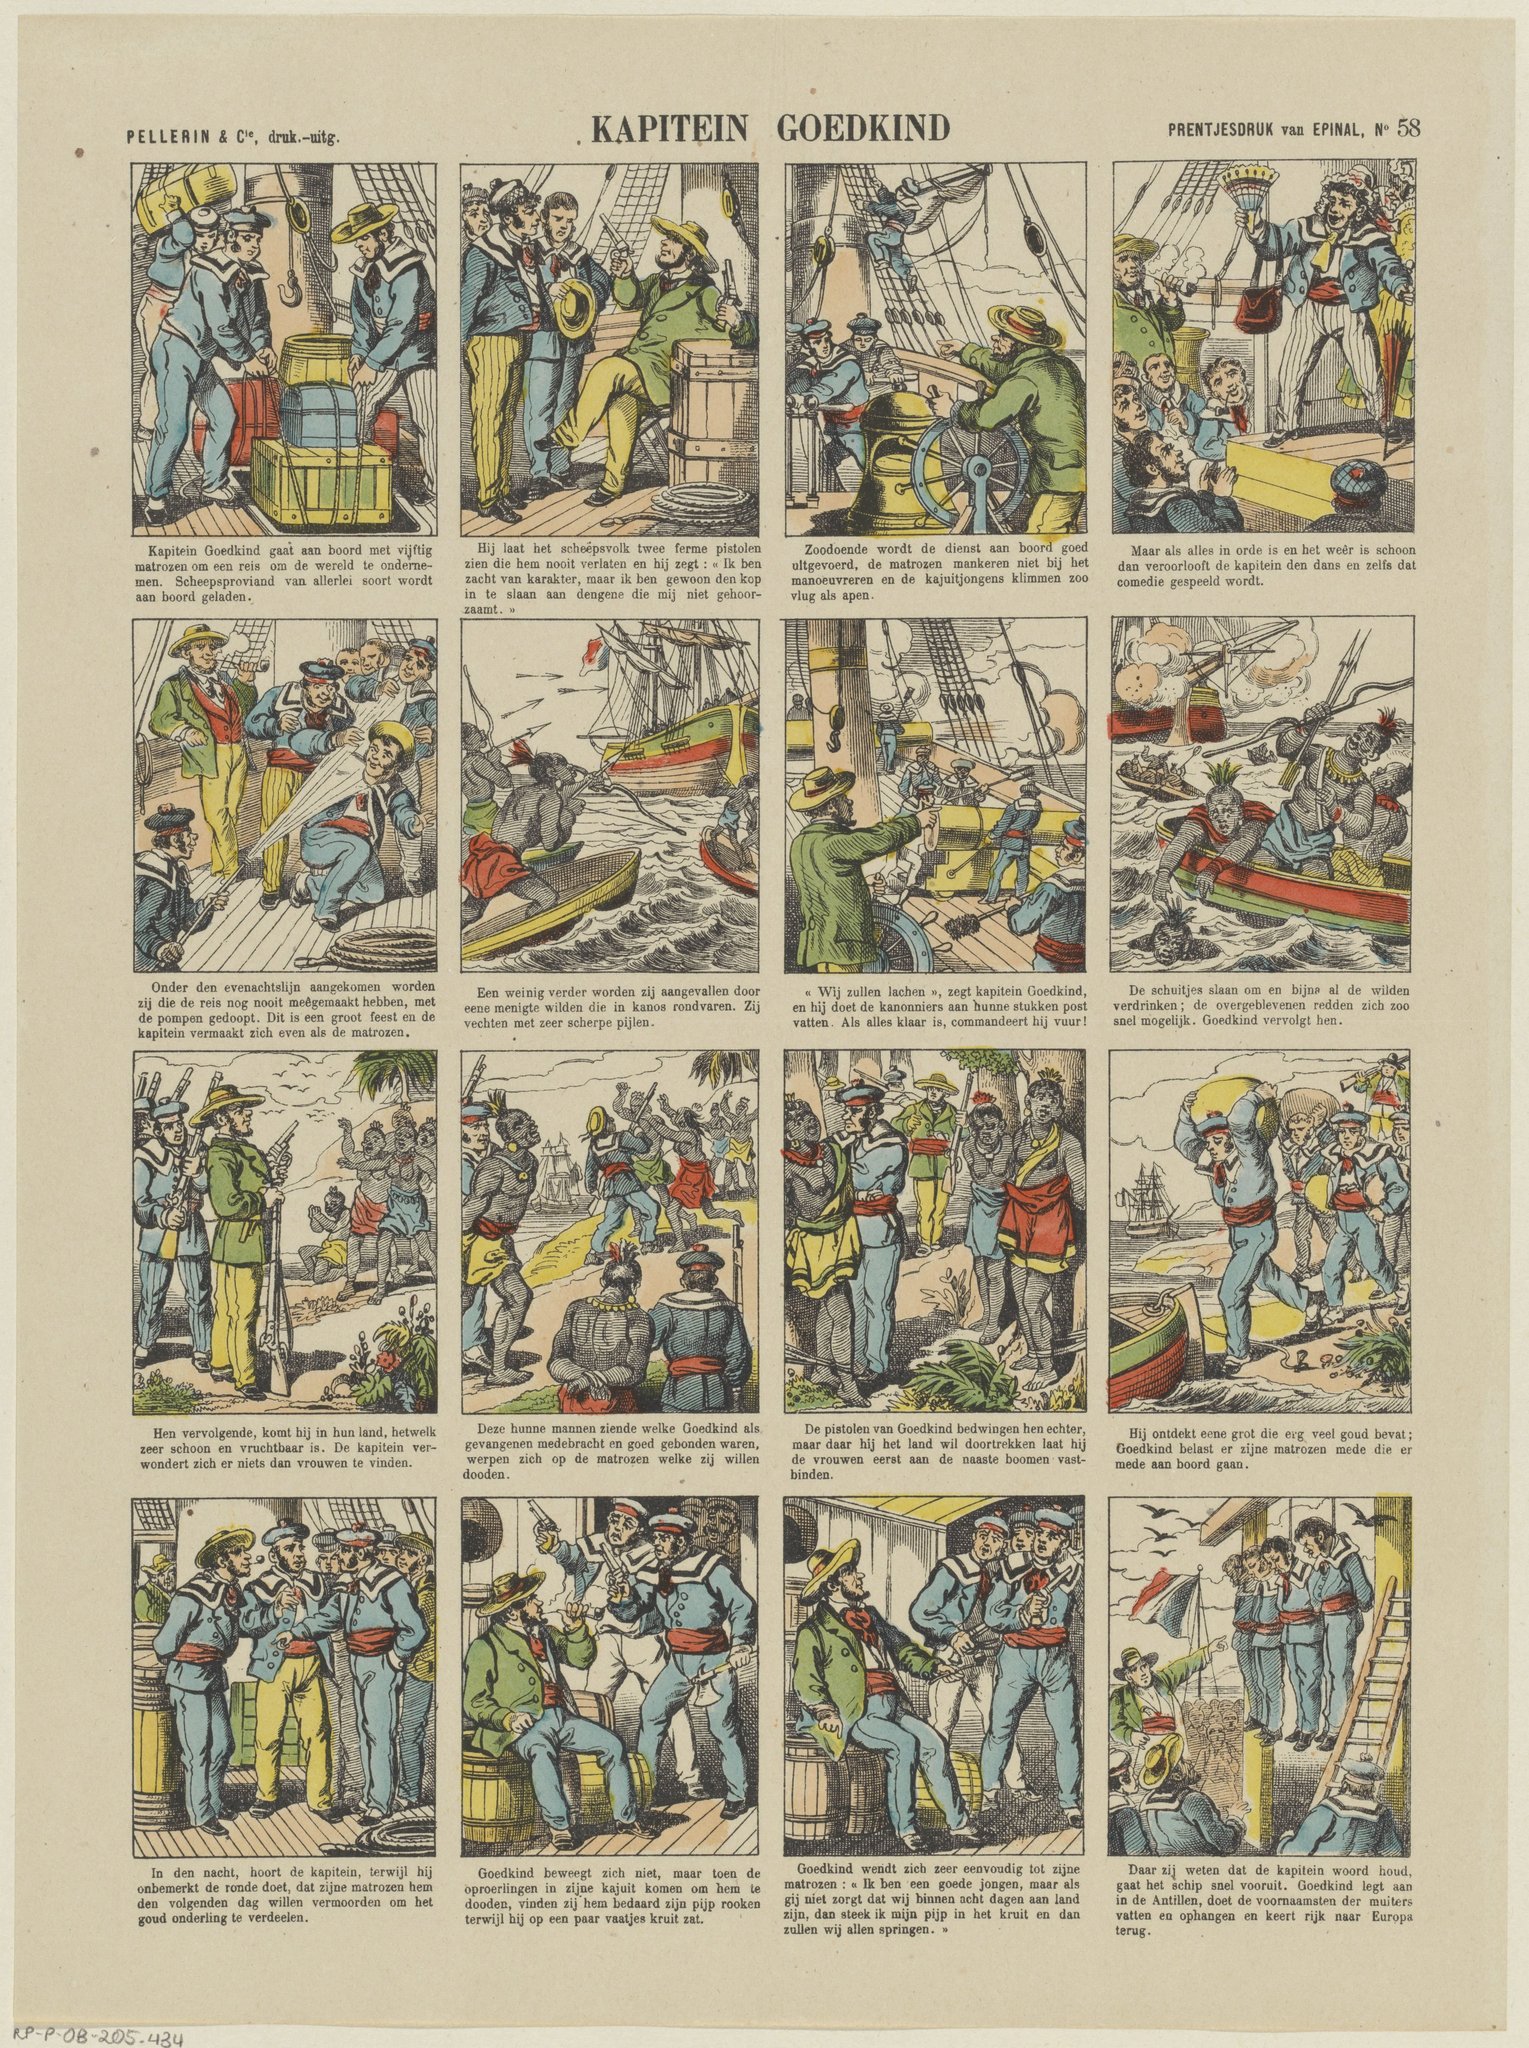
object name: print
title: Kapitein Goedkind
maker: Anonymous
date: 1902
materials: paper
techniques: colour, letterpress printing, lithograph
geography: epinal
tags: world tour, e.g.: world cruise, tales and fairy tales, seaman: sailor, mutiny on ship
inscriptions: collector's mark: Lugt 2760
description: Blad met 16 voorstellingen uit het verhaal van kapitein Goedkind die een wereldreis maakt. Onder elke afbeelding een onderschrift. Genummerd rechtsboven: No 58.